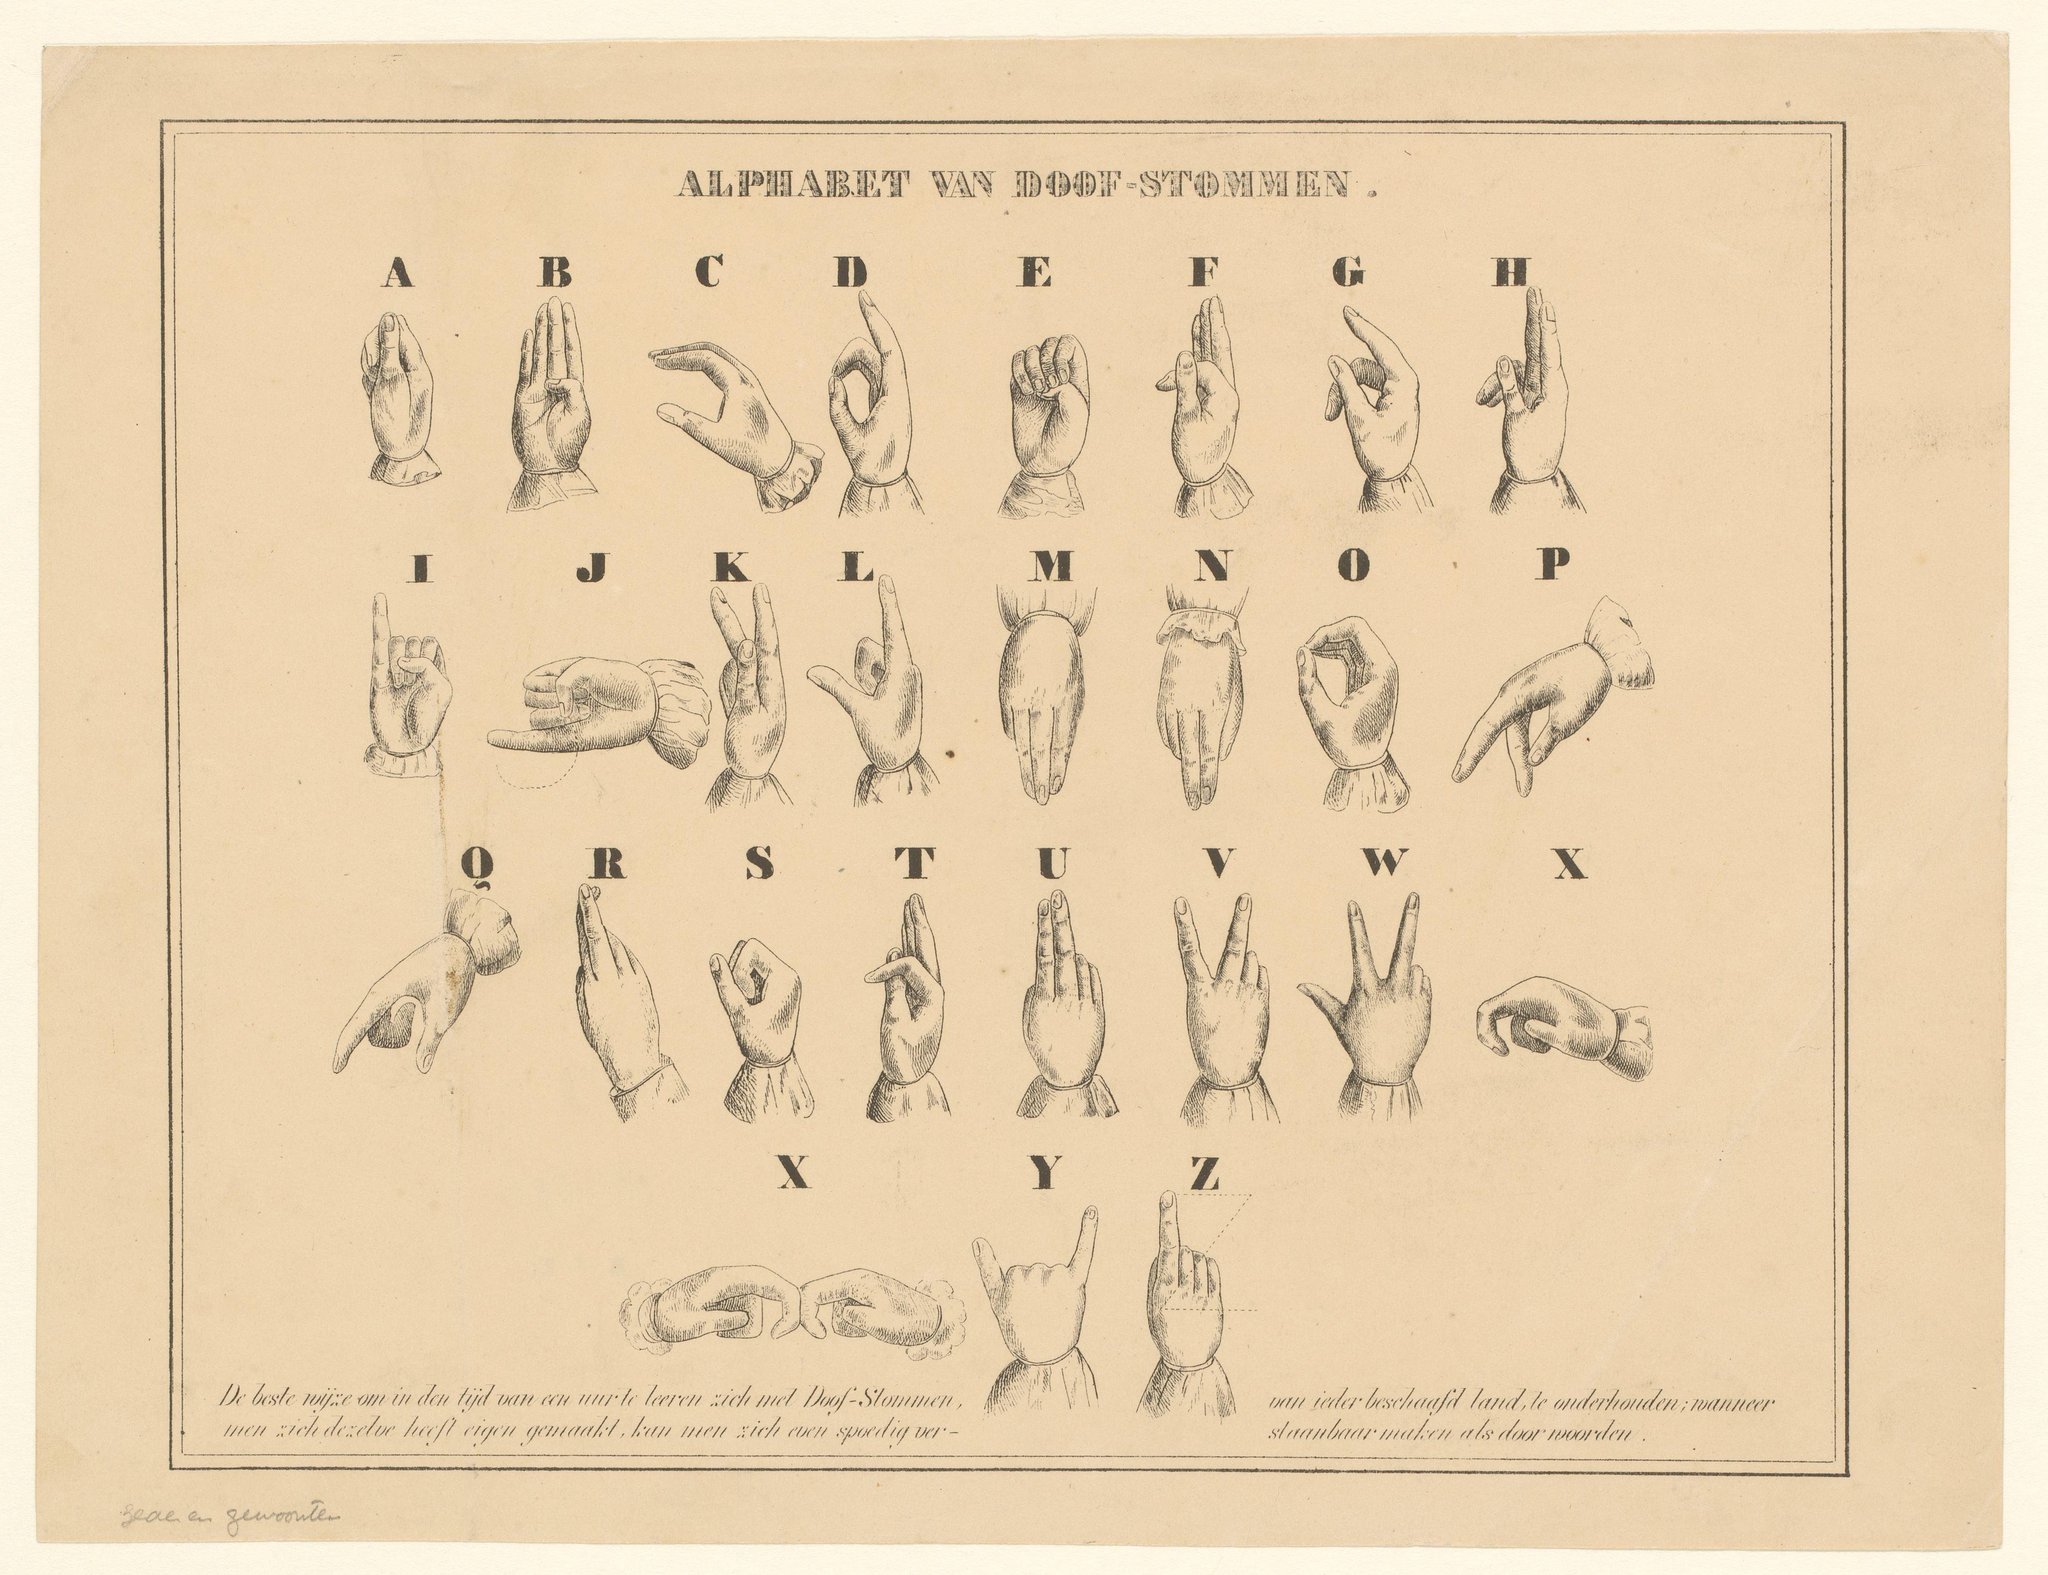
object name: print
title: Alfabet in gebarentaal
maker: Anonymous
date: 1800-1900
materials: paper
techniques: lithograph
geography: netherlands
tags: postures and gestures of hand and fingers, deaf, deafness, roman script; scripts based on the roman alphabet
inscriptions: collector's mark: Lugt 2233